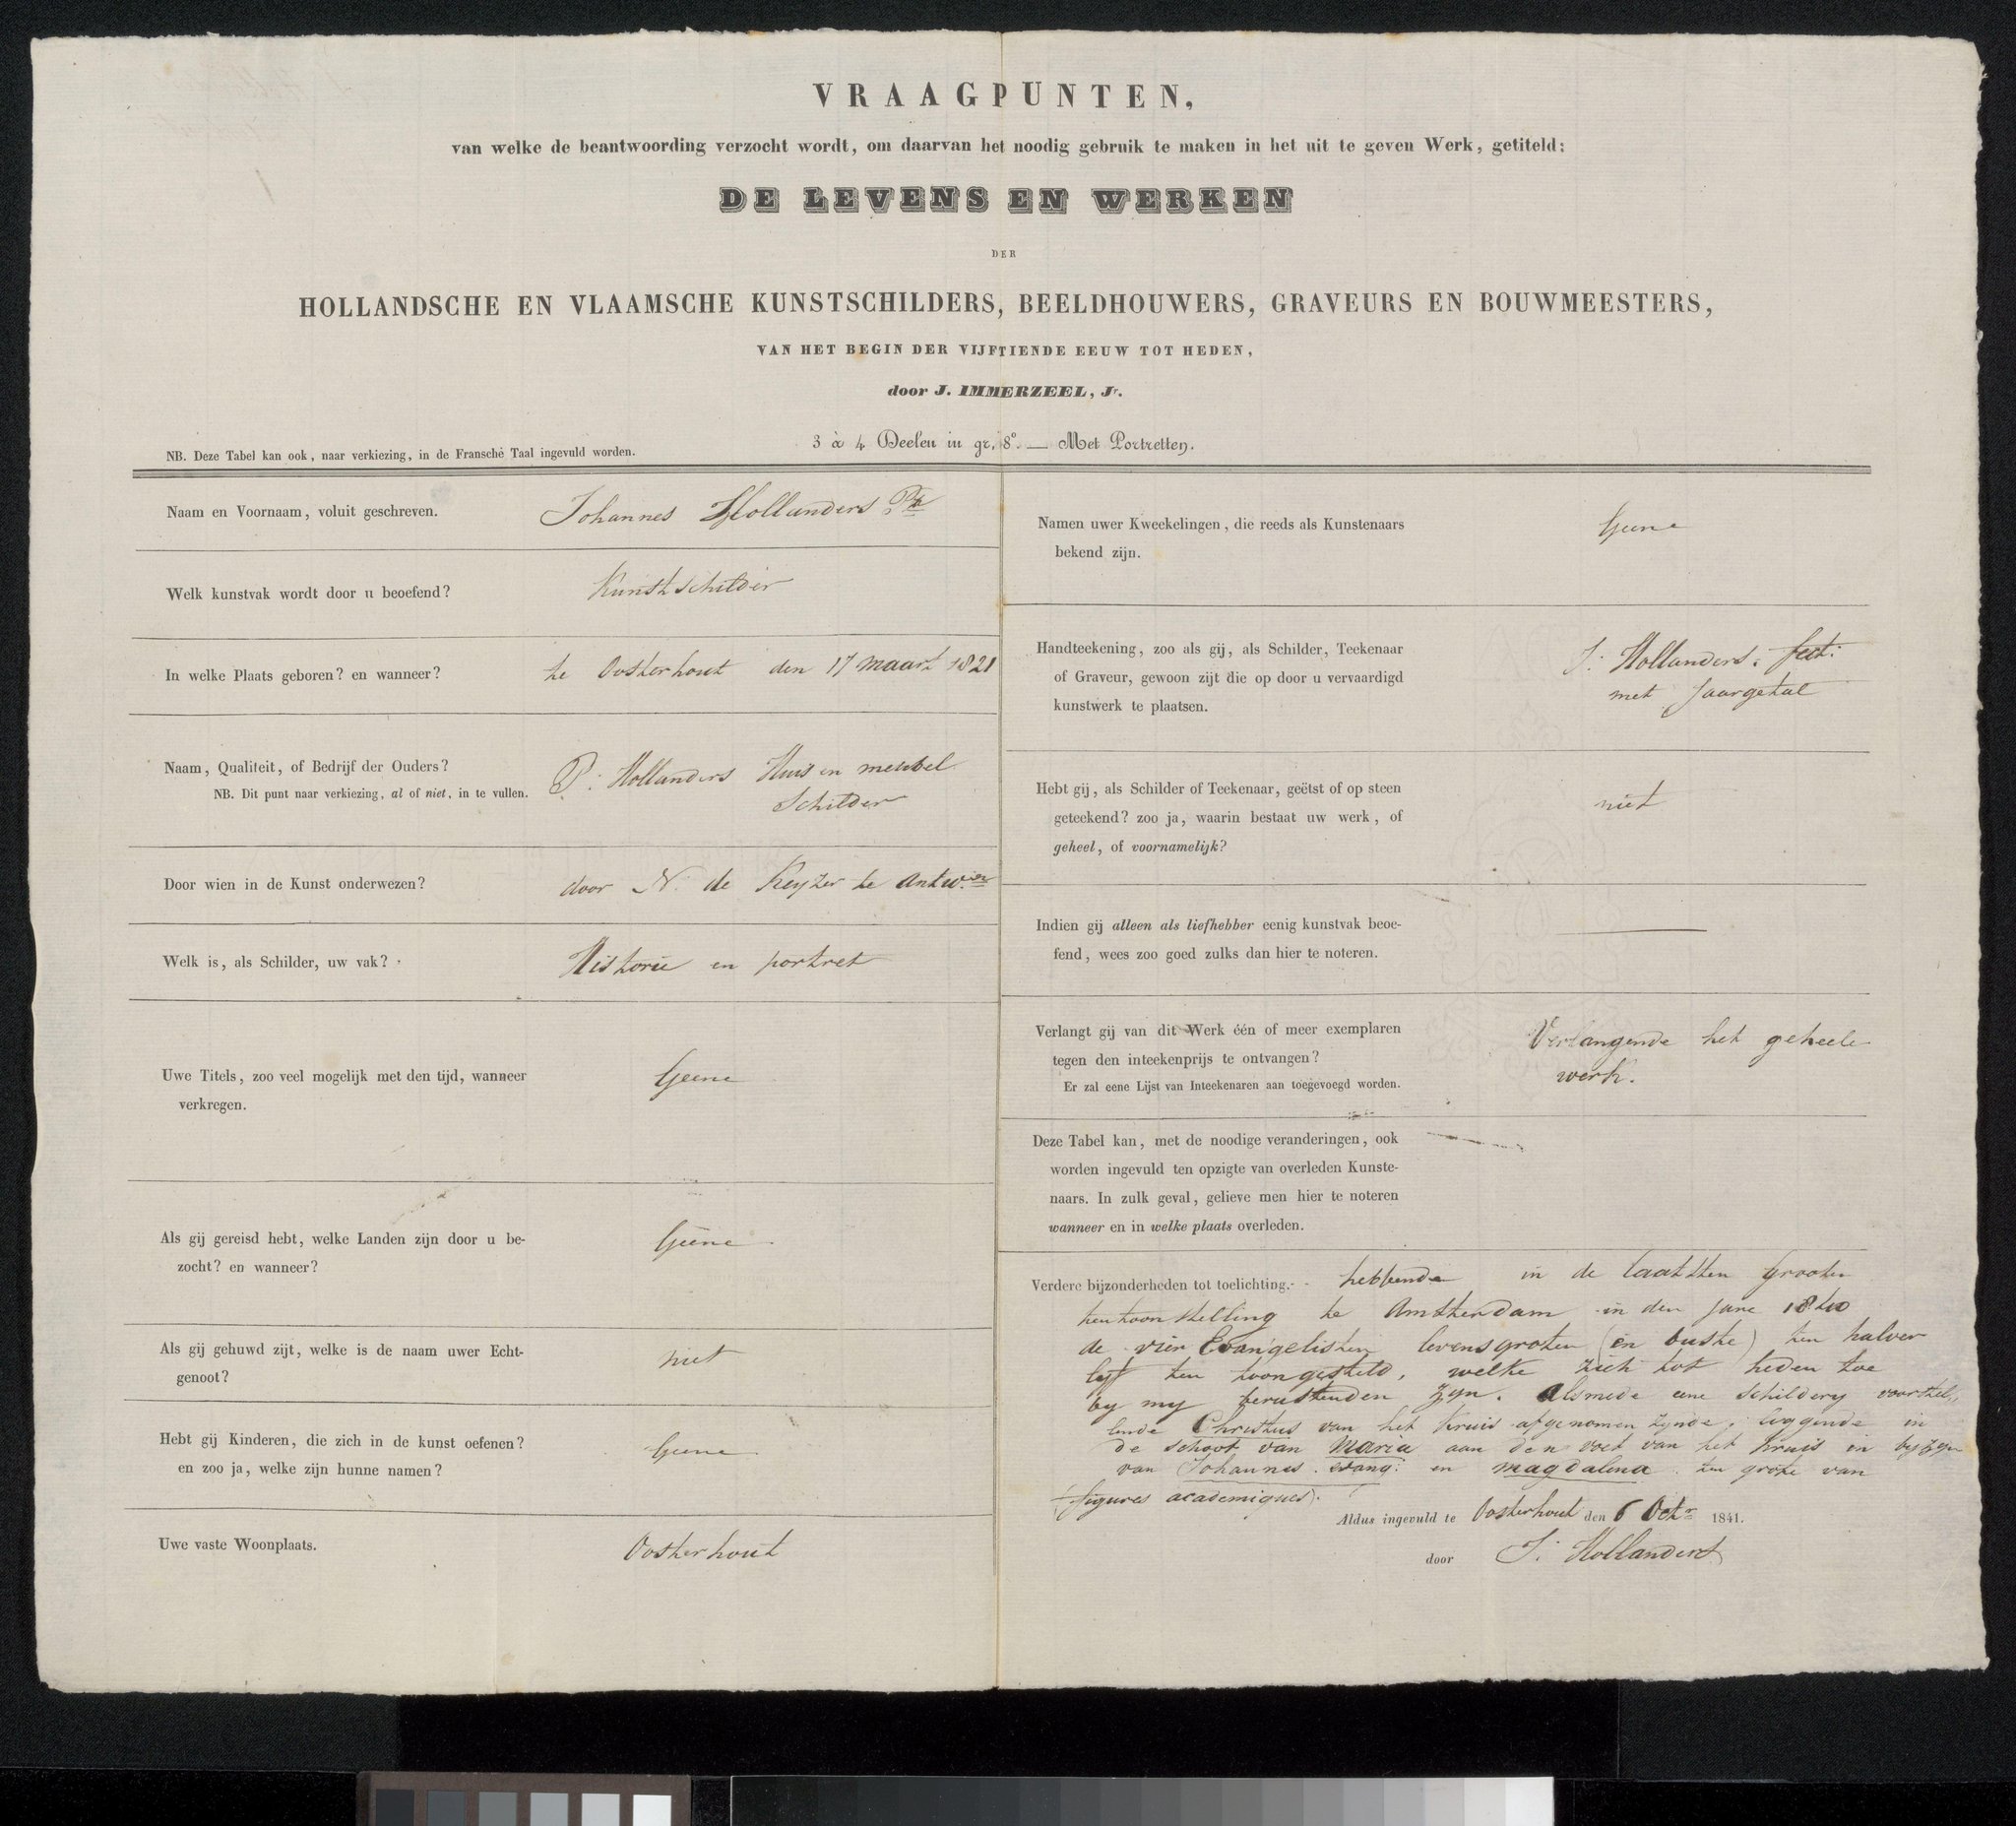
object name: questionnaire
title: Enquêteformulier ingevuld door Johannes Hollanders Pzn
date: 1841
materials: ink, paper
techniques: pen, printing, writing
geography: oosterhout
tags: painter, johannes hollanders pzn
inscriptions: inscription: ‘Vraagpunten,/ van welke de beantwoording verzocht wordt, om daarvan het noodig gebruik te maken in het uit te geven Werk, getiteld: De levens en werken/ der Hollandsche en Vlaamsche kunstschilders, beeldhouwers,/ graveurs en bouwmeesters, van het begin der vijftiende eeuw tot heden/ door J. Immerzeel, Jr.’, watermark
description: Opgenomen in: Immerzeel, J. Jr., De levens en werken der Hollandsche en Vlaamsche kunstschilders, beeldhouwers, graveurs en bouwmeesters, van het begin der vijftiende eeuw tot heden, Amsterdam: J.C. van Kesteren, 1842-1843.